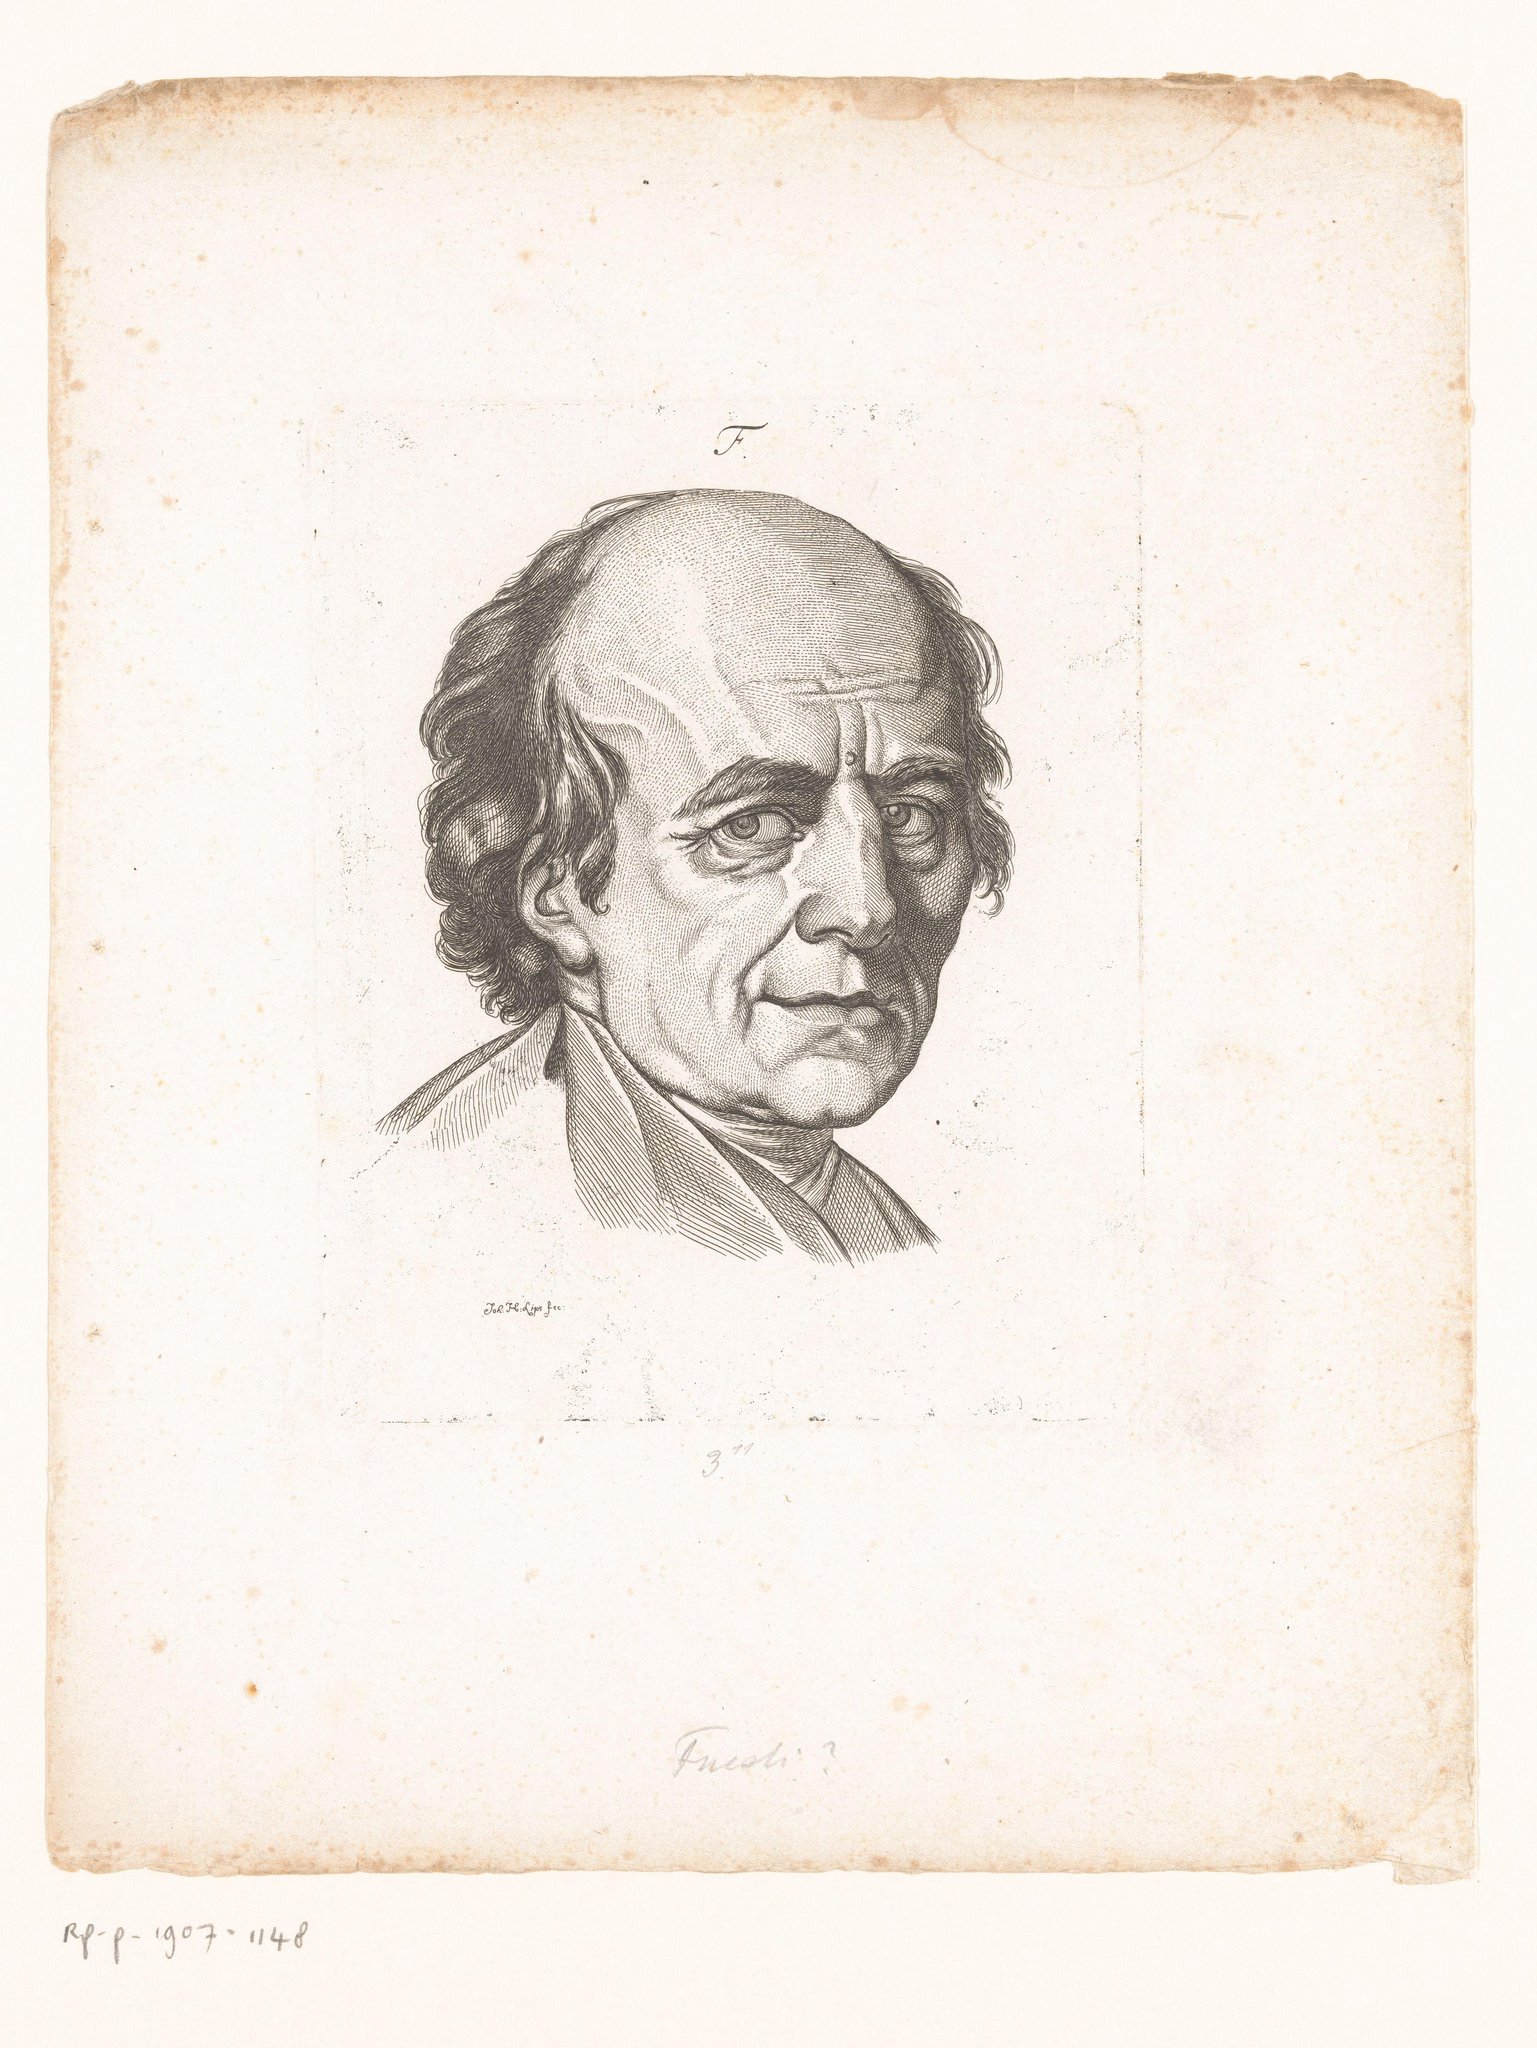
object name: print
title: Portret van Johann Heinrich Fuessli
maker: johann heinrich lips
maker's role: draughtsman, painter, print maker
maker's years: 1758-1817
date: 1768-1817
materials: paper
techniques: engraving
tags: print maker, draughtsman, johann heinrich füssli, historical persons, portrait, self-portrait of artist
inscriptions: collector's mark: Lugt 2228